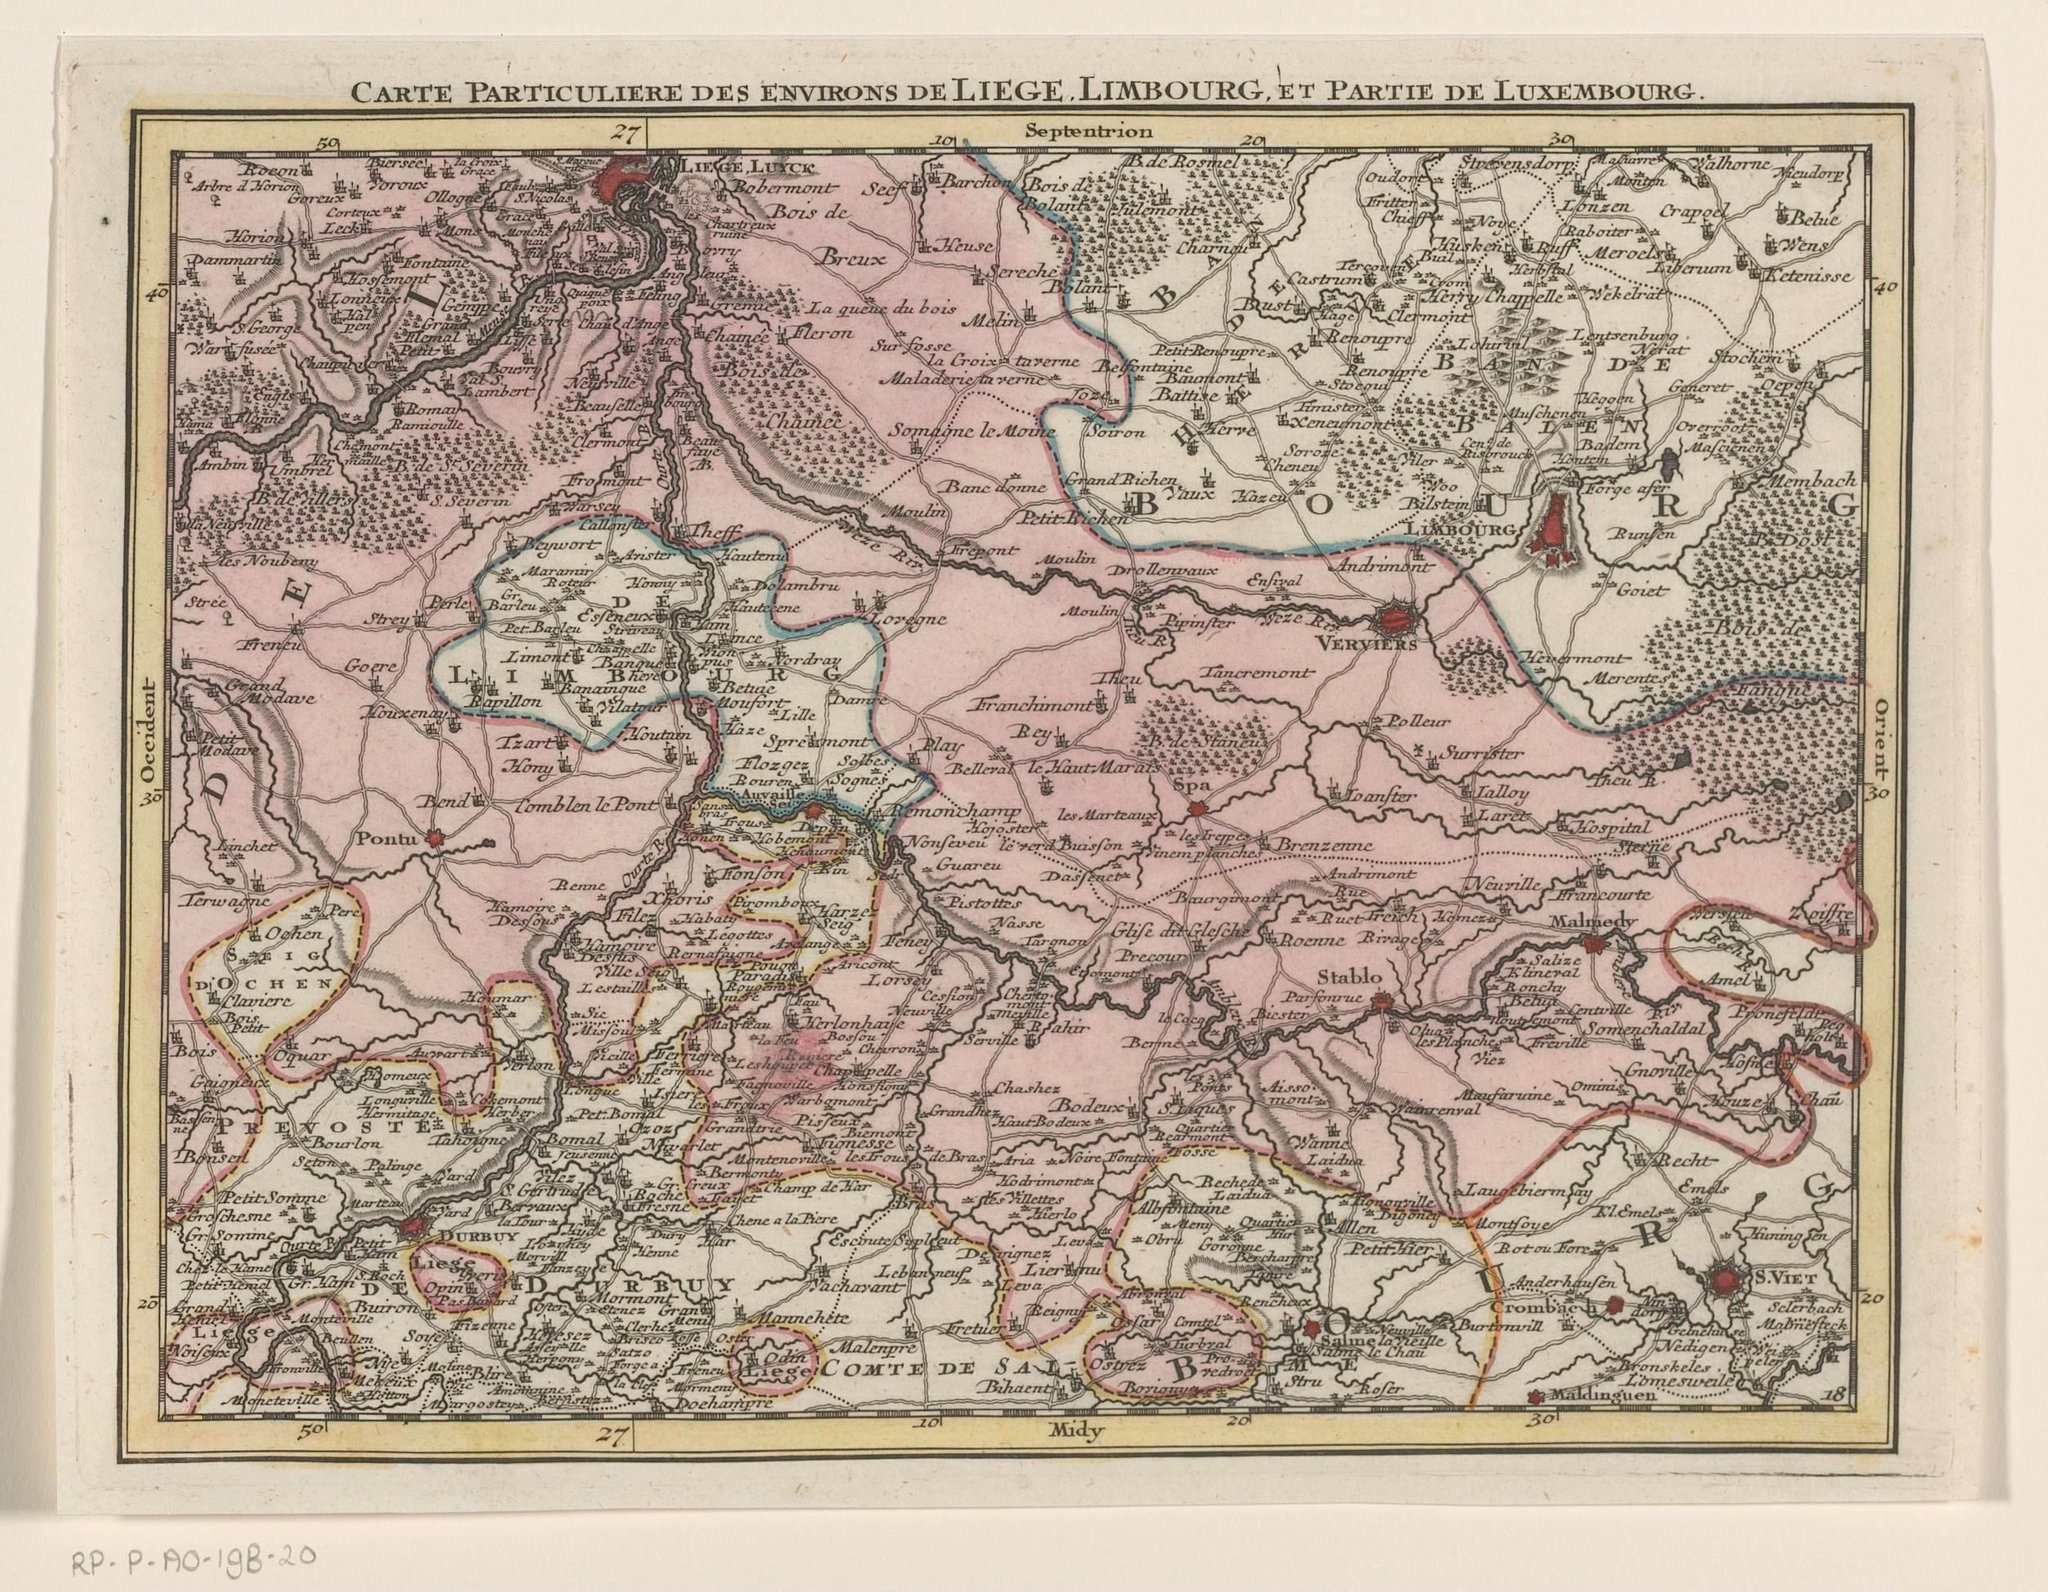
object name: print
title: Deel van een kaart van de Oostenrijkse Nederlanden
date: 1737-1757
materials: paper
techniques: engraving, hand coloring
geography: augsburg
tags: maps of separate countries or regions, southern netherlands, belgium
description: Deze kaart is onderdeel van een wandkaart van de Oostenrijkse Nederlanden, bestaande uit vier rijen van zes delen. De delen van de kaart zijn rechtsonder genummerd, beginnend bij het deel linksboven (1) tot het deel rechtsonder (24).